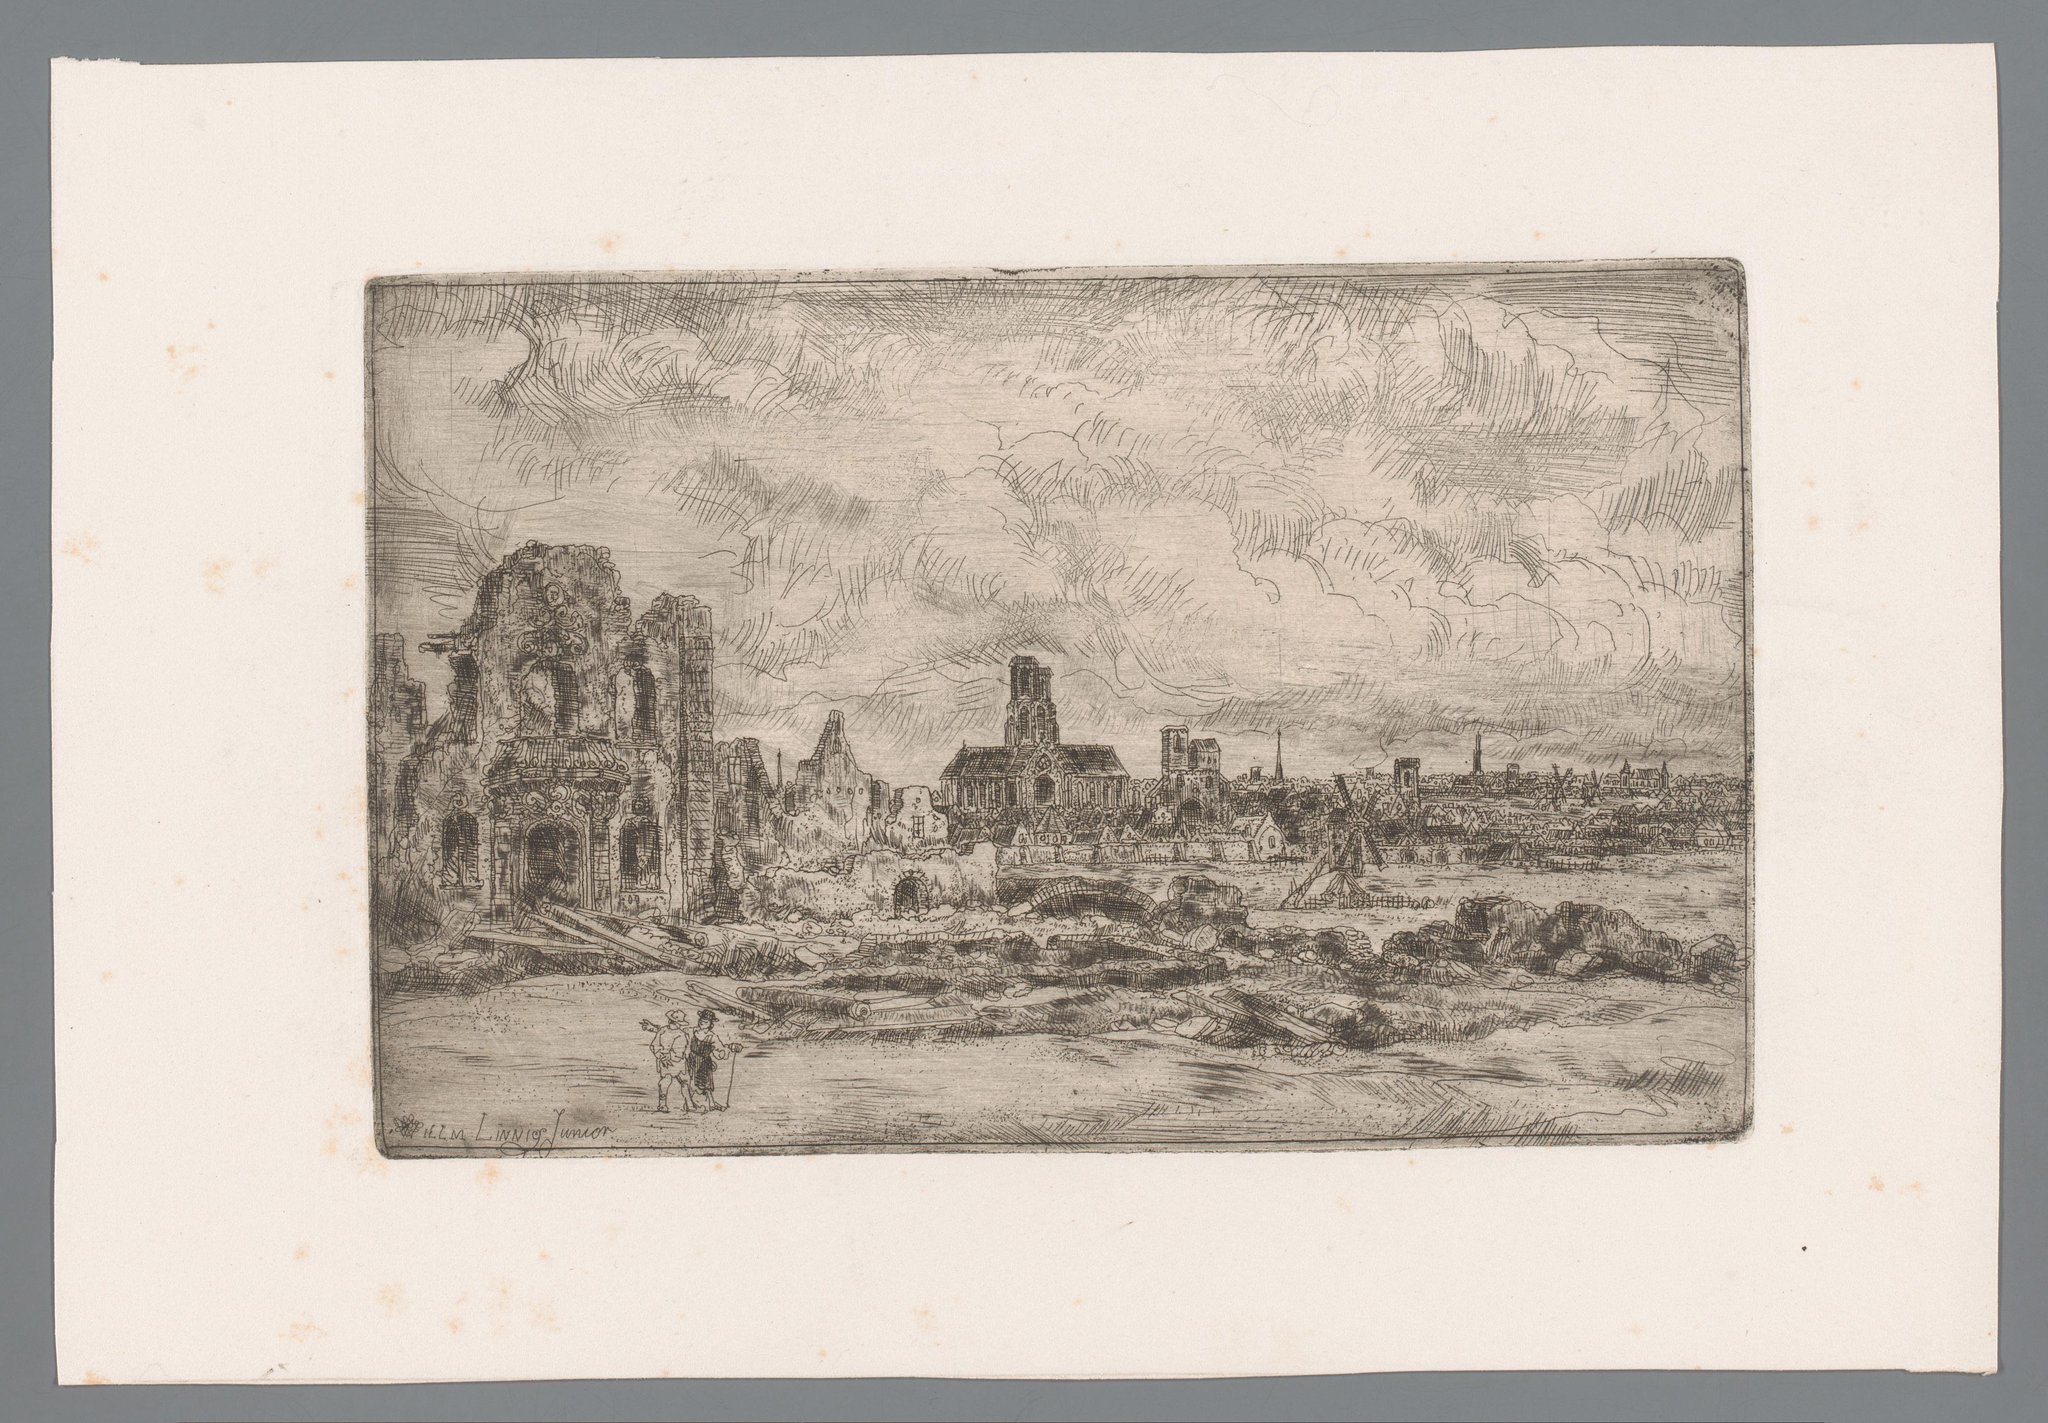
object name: print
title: Stadsgezicht met een ruïne en twee figuren op de voorgrond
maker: willem linnig (ii)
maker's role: print maker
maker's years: 1842-1890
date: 1852-1890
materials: paper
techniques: drypoint, etching, intaglio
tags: windmill, prospect of city, town panorama, silhouette of city, ruin of a dwelling, house, castle, etc.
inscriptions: collector's mark: Lugt 2228